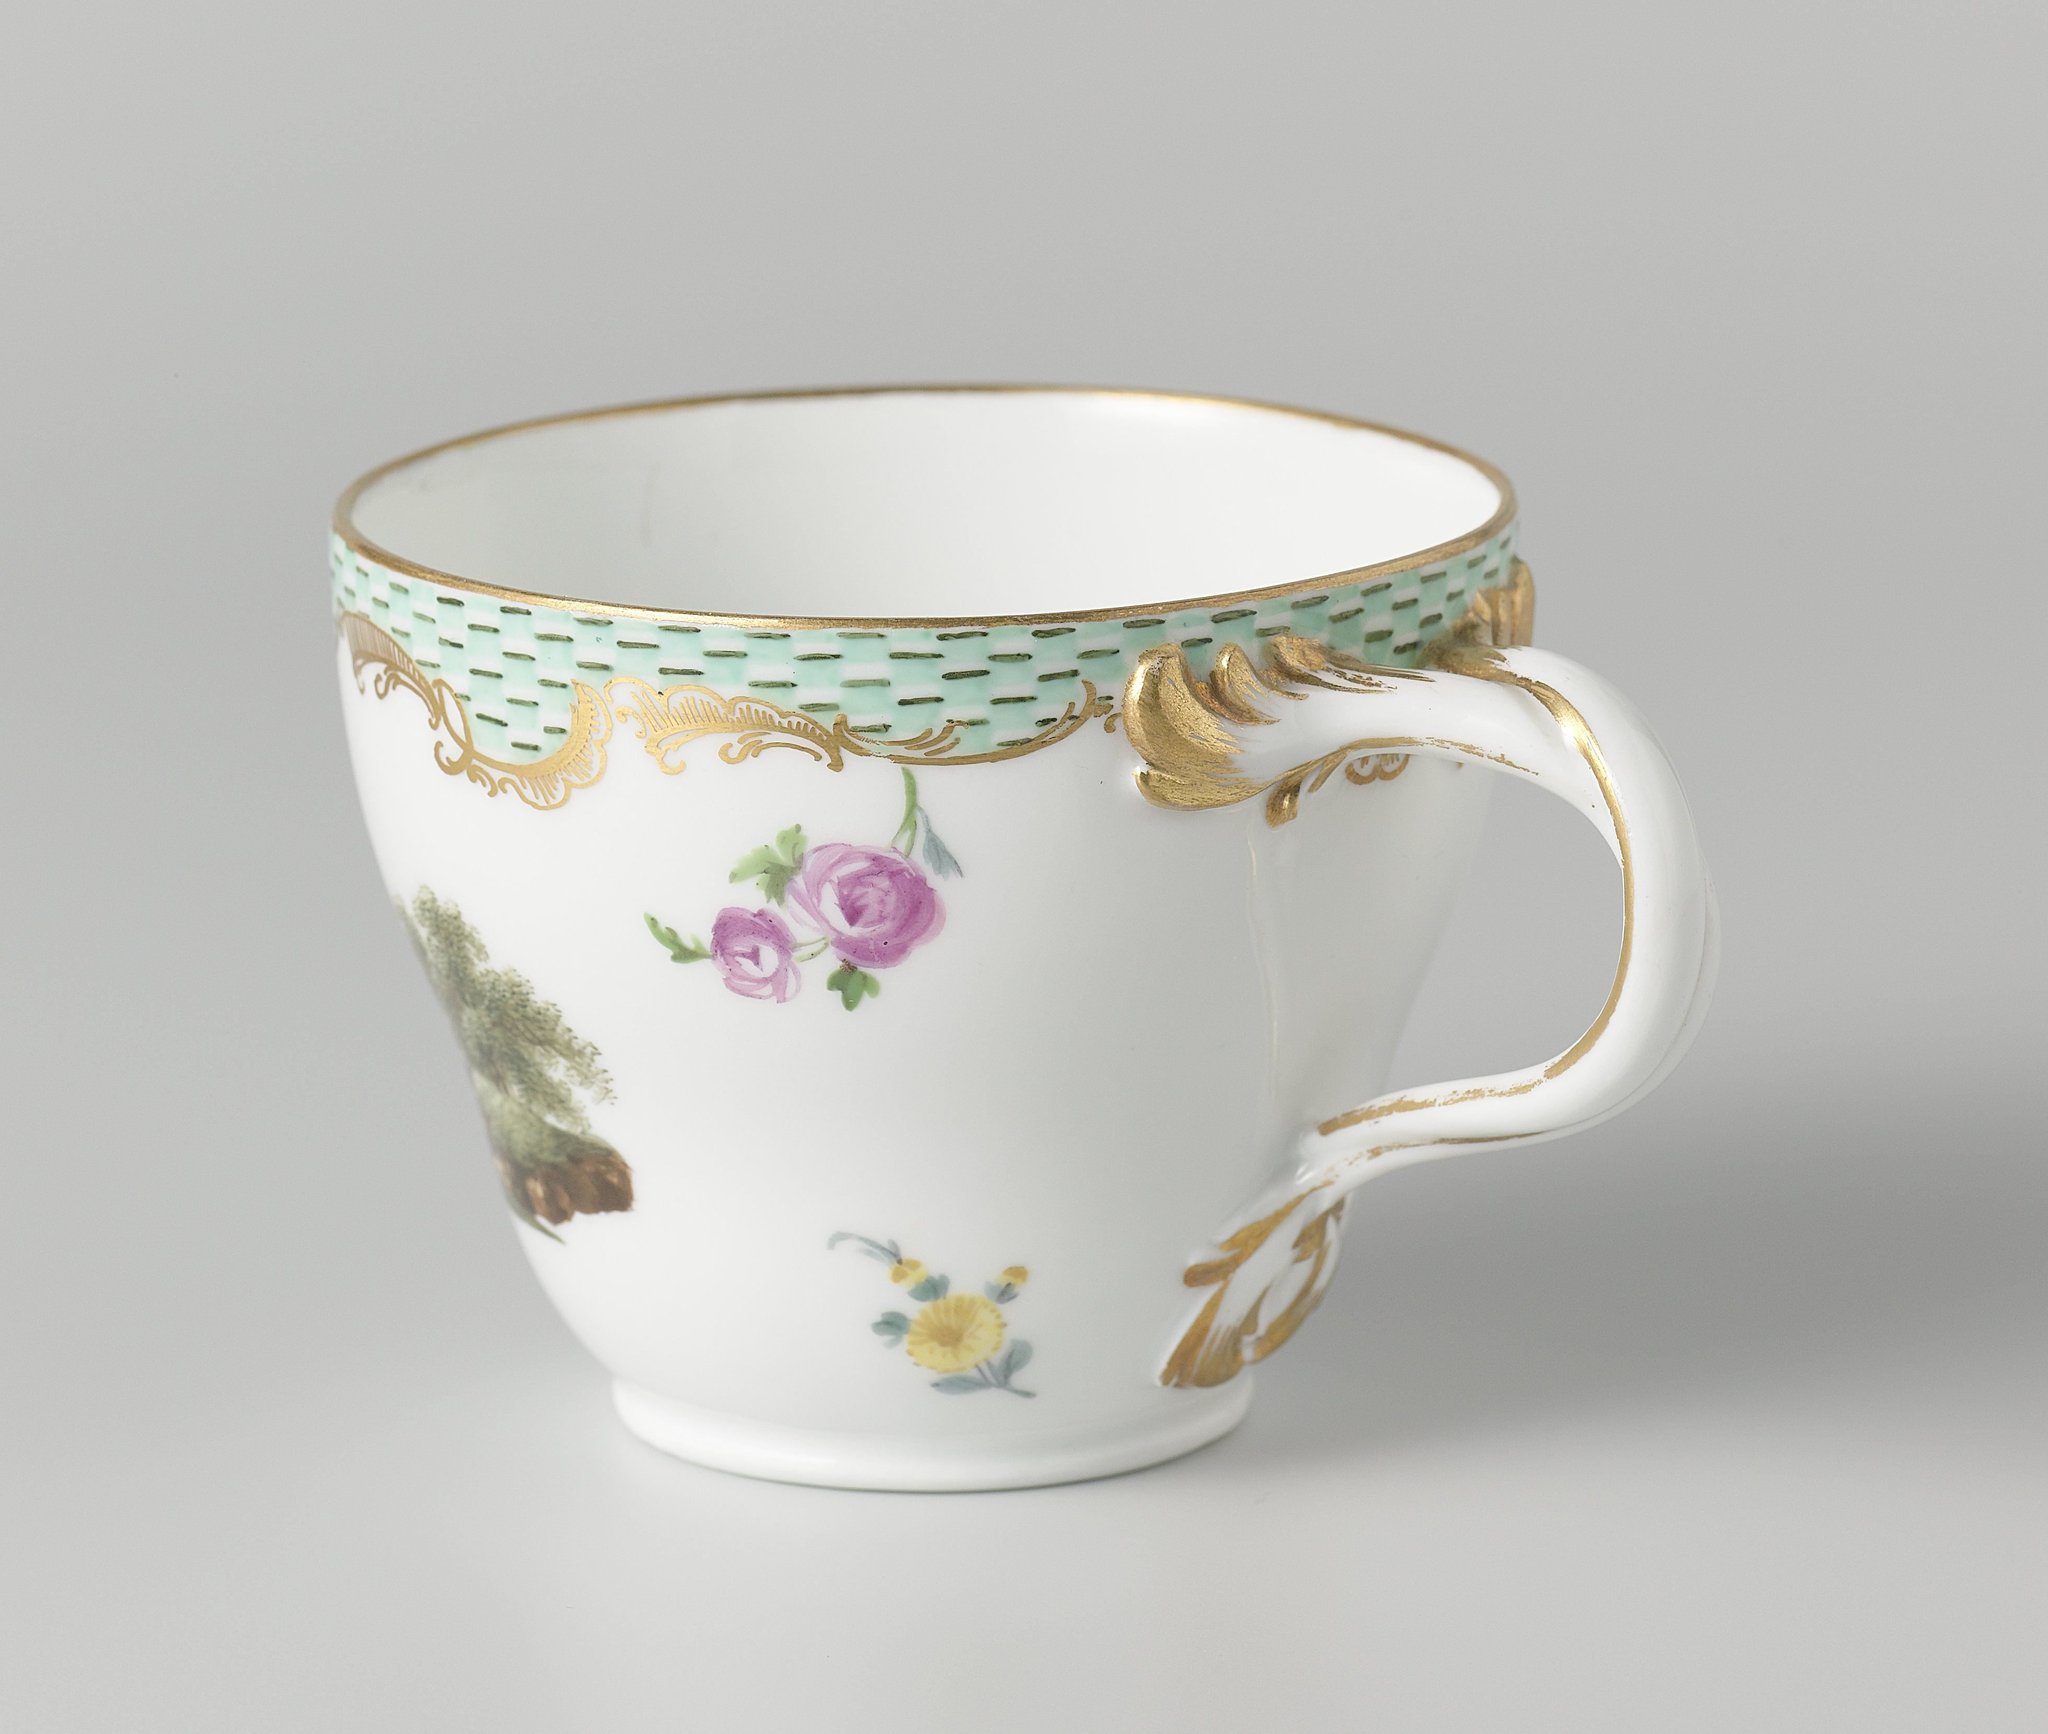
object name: eating drinking utensil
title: Kop, veelkleurig beschilderd met een landschap met figuren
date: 1777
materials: porcelain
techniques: painted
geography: meissen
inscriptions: factory mark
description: Hoge kop met oor, van beschilderd porselein. De kop is beschilderd met landschappen waarin figuren en langs de rand een brede strook groen vlechtwerk. De kop is gemerkt.